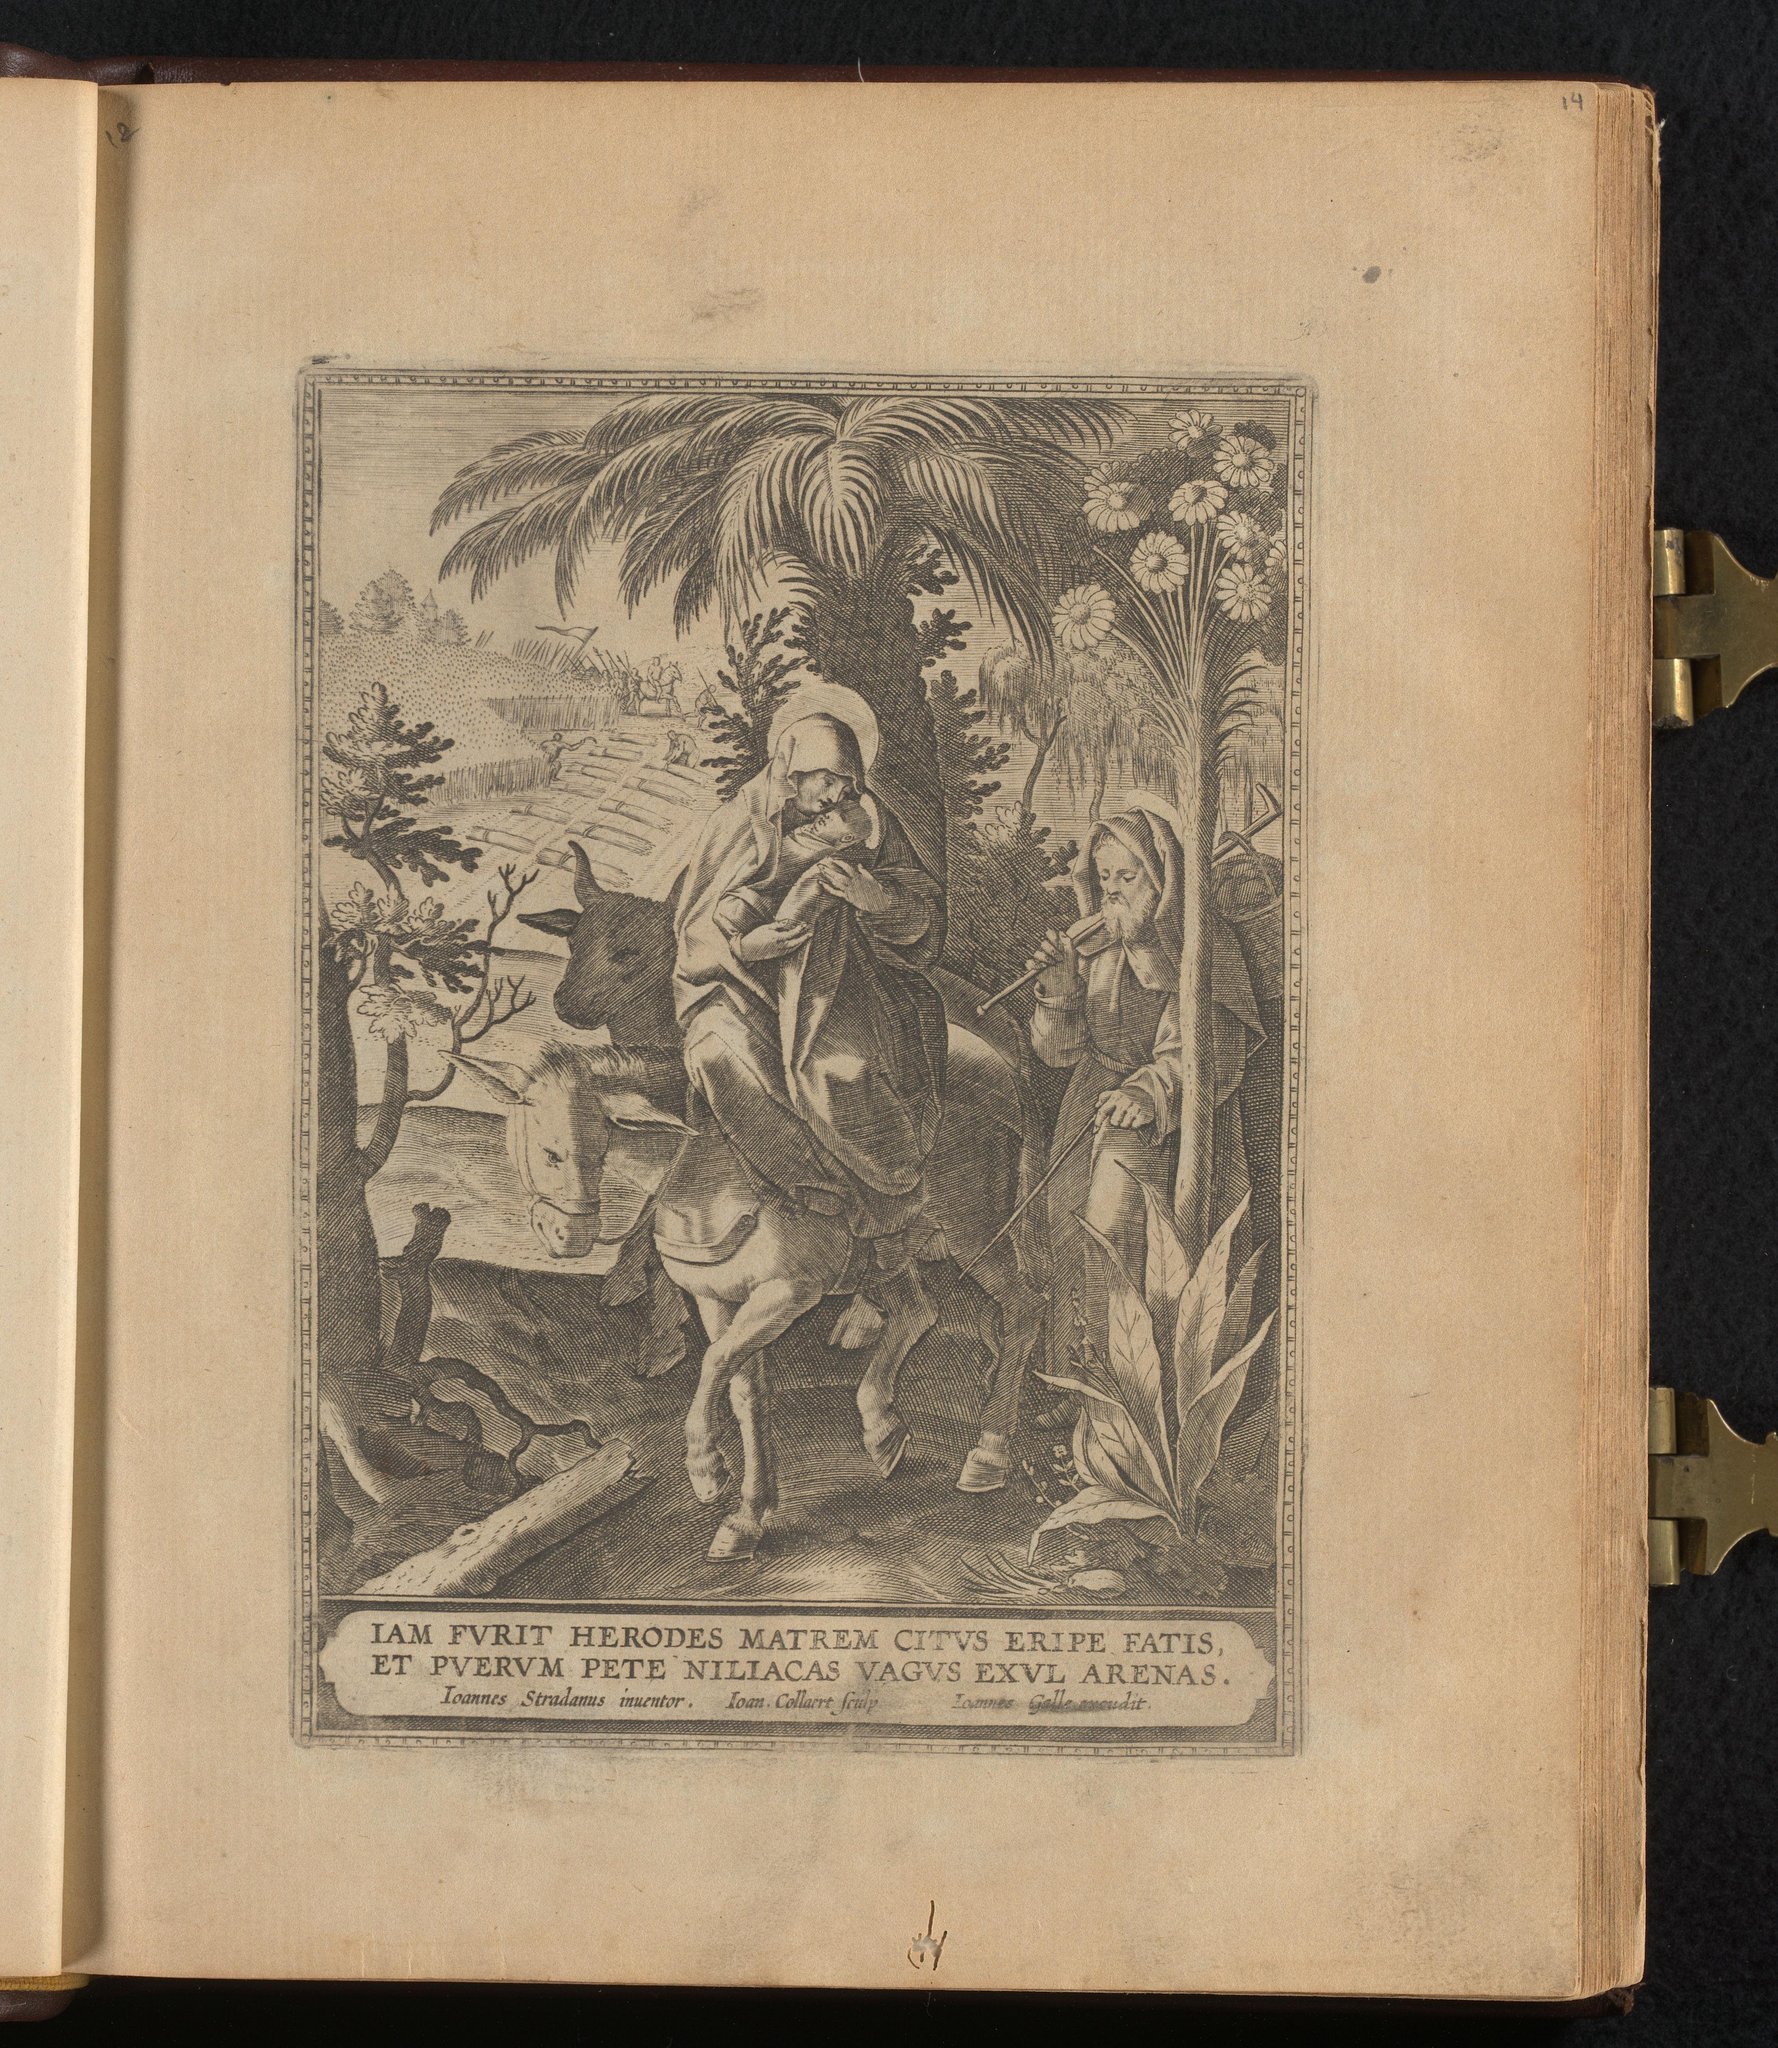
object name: print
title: Vlucht naar Egypte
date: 1783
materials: paper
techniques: engraving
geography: antwerp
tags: flight into egypt and miracles during the journey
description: Prent in: s.n. Aldernouwkeurigste verhandelinge der geschiedenissen van het Nieuw Testament (...). Antwerpen: Cornelis Marten Spanoghe, 1783, p. 18-19.